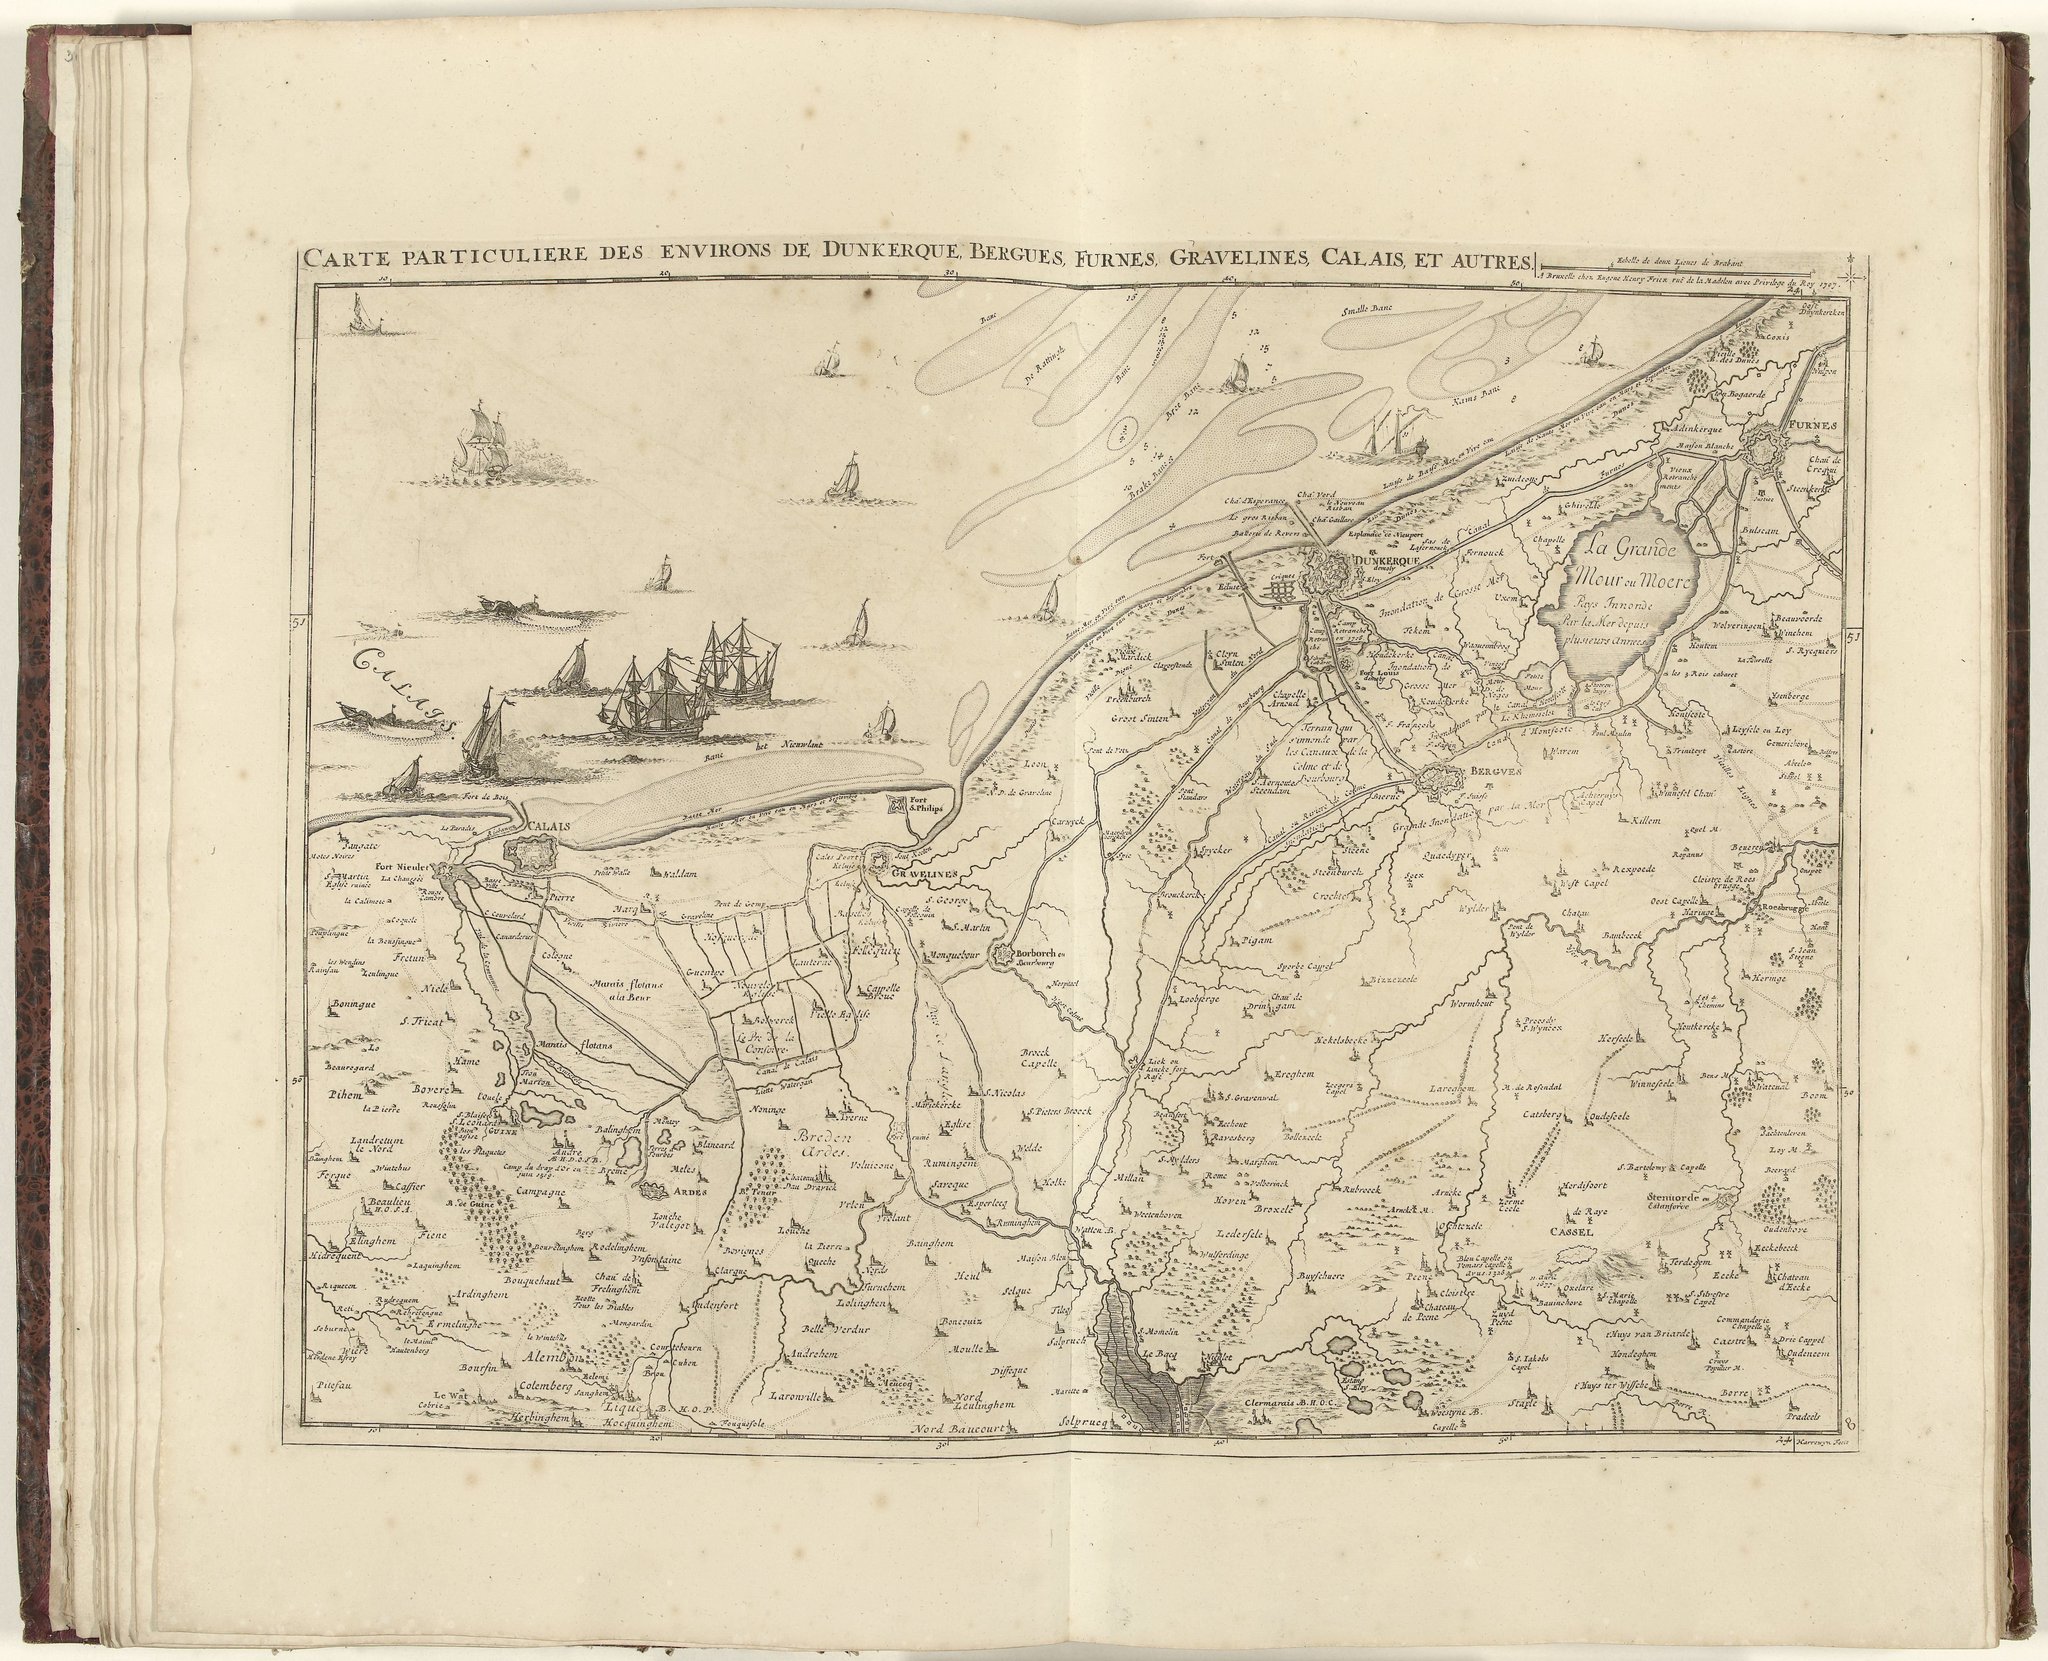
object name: map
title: Kaart van de Noord-Franse kust, 1707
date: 1707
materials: paper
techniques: engraving, etching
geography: brussels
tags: marine charts, northern france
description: Kaart van de Noord-Franse kust tussen Duinkerke en Calais, 1707. Onderdeel van een gebundelde verzameling van plannen van veldslagen en steden vermaard in de Spaanse Successieoorlog. Deze plaat behoort tot de eerste 24 platen die samen een zeer grote kaart van de Zuidelijke Nederlanden vormen.